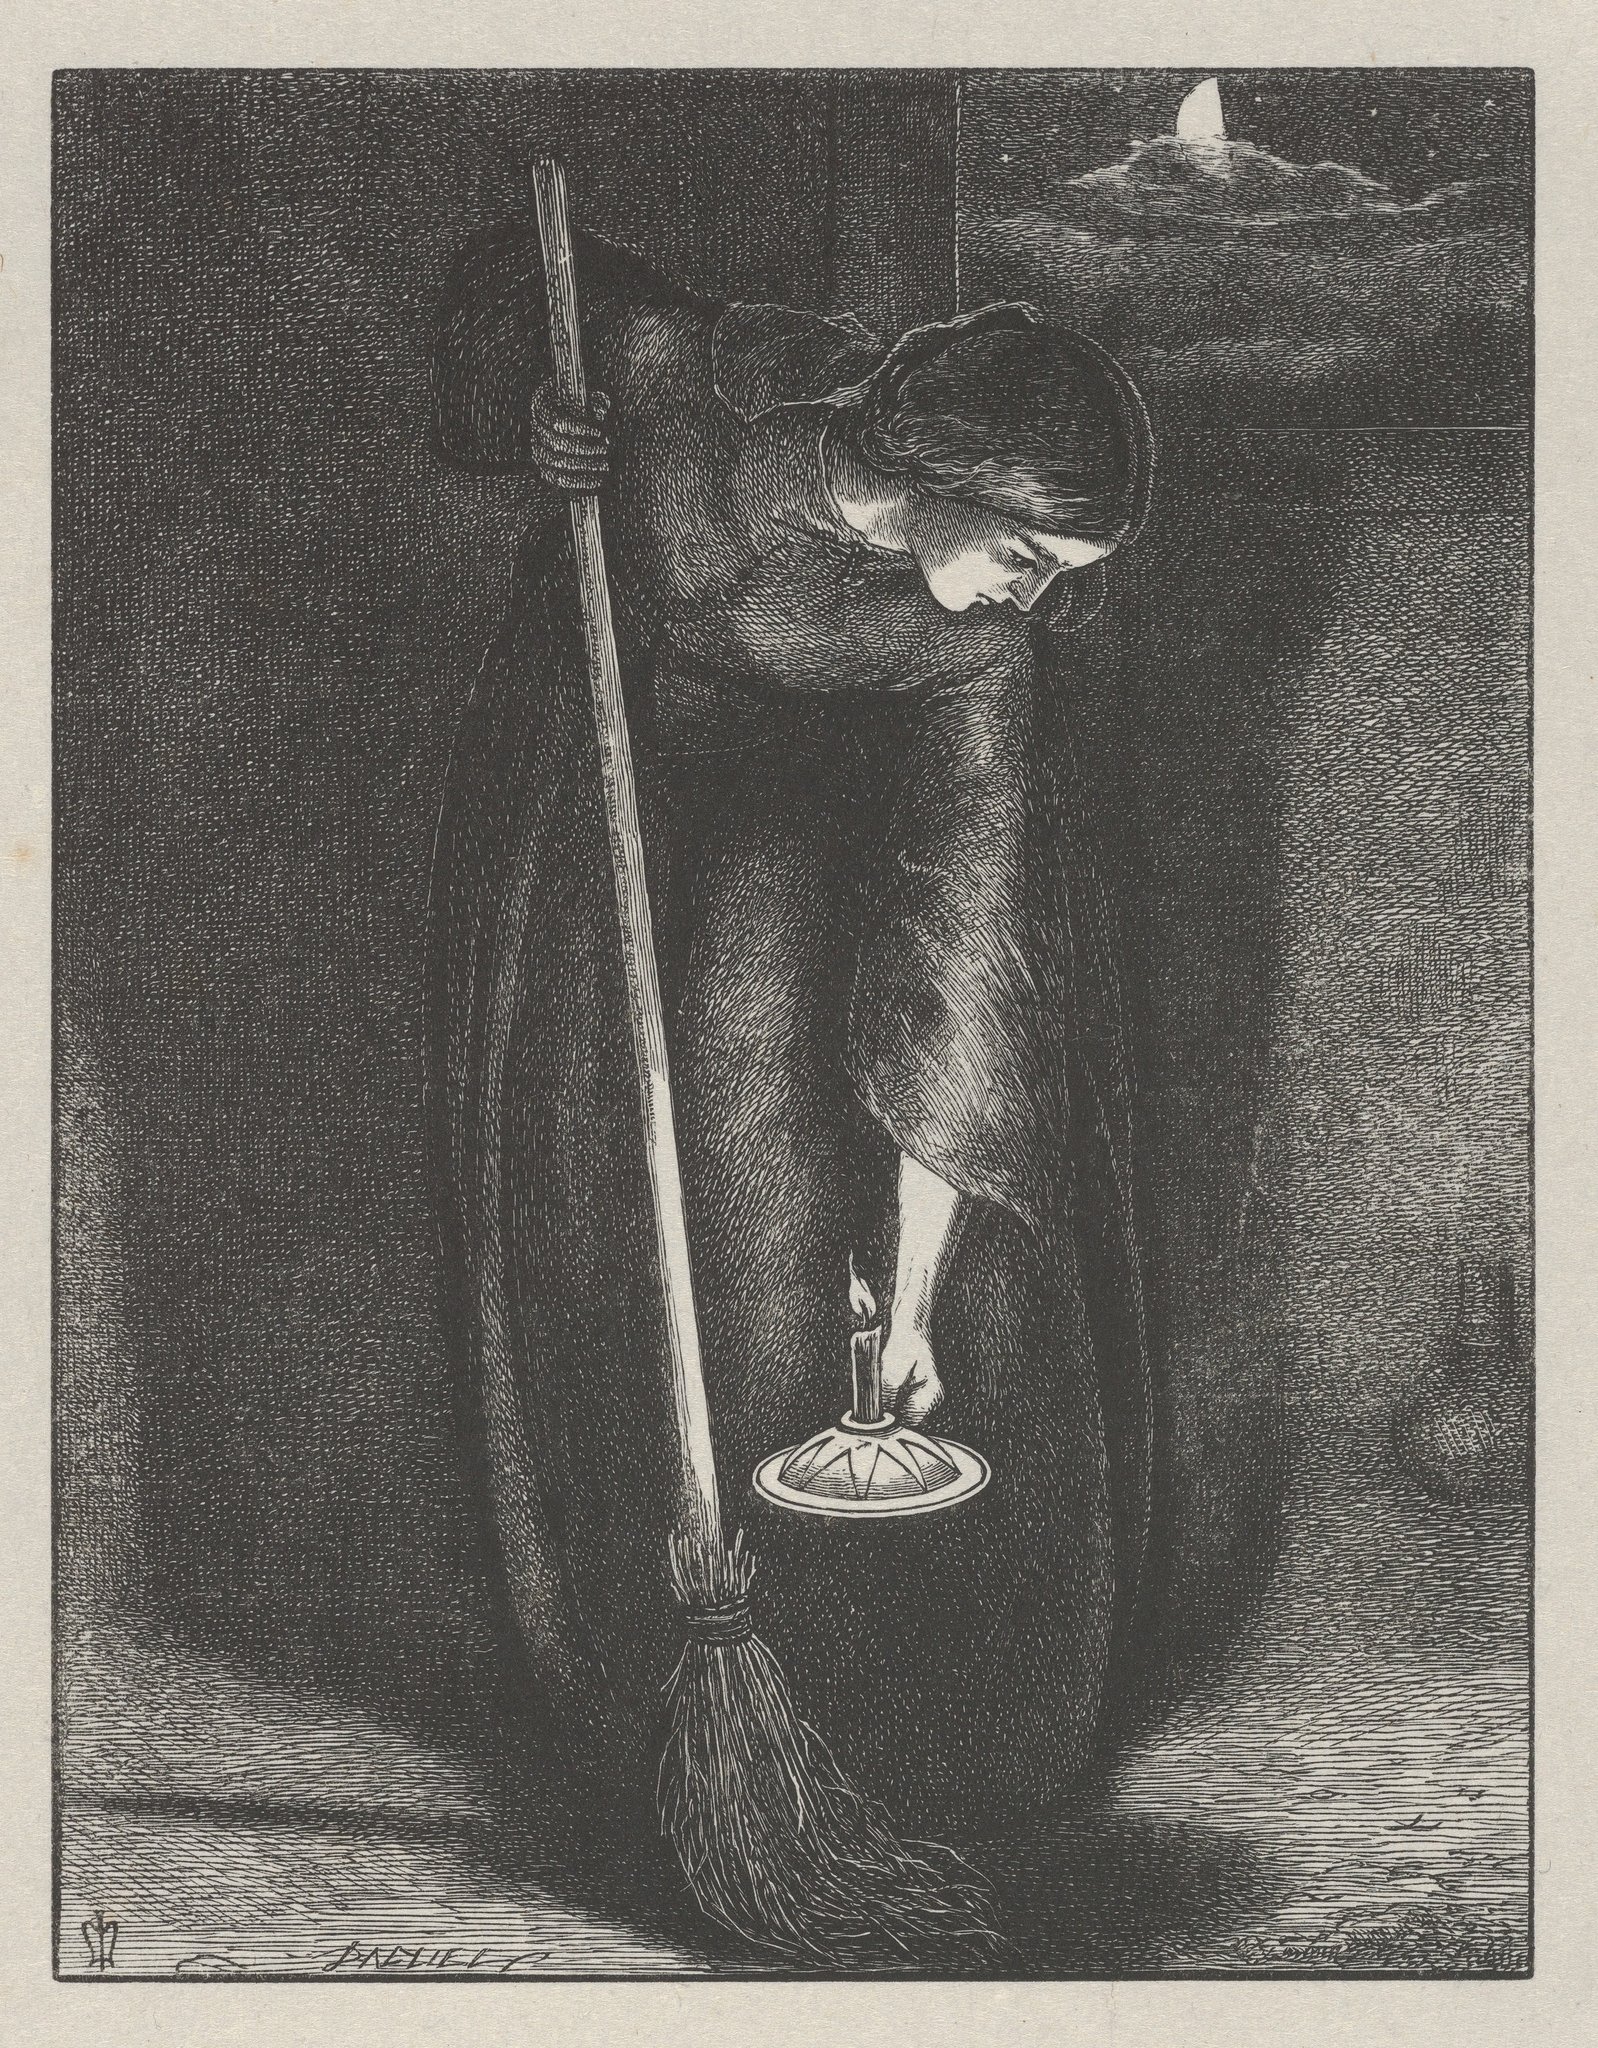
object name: print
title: The Lost Piece of Silver (The Parables of Our Lord and Saviour Jesus Christ)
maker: sir john everett millais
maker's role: artist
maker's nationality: british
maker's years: 1829-1896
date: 1864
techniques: engraving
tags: women,candles,brooms